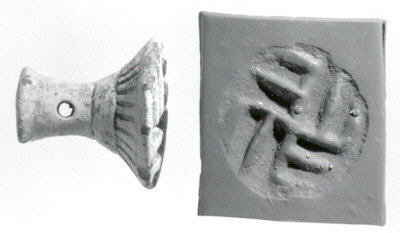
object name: stamp seal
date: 2000-1001 BCE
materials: ceramic, faience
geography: central asia